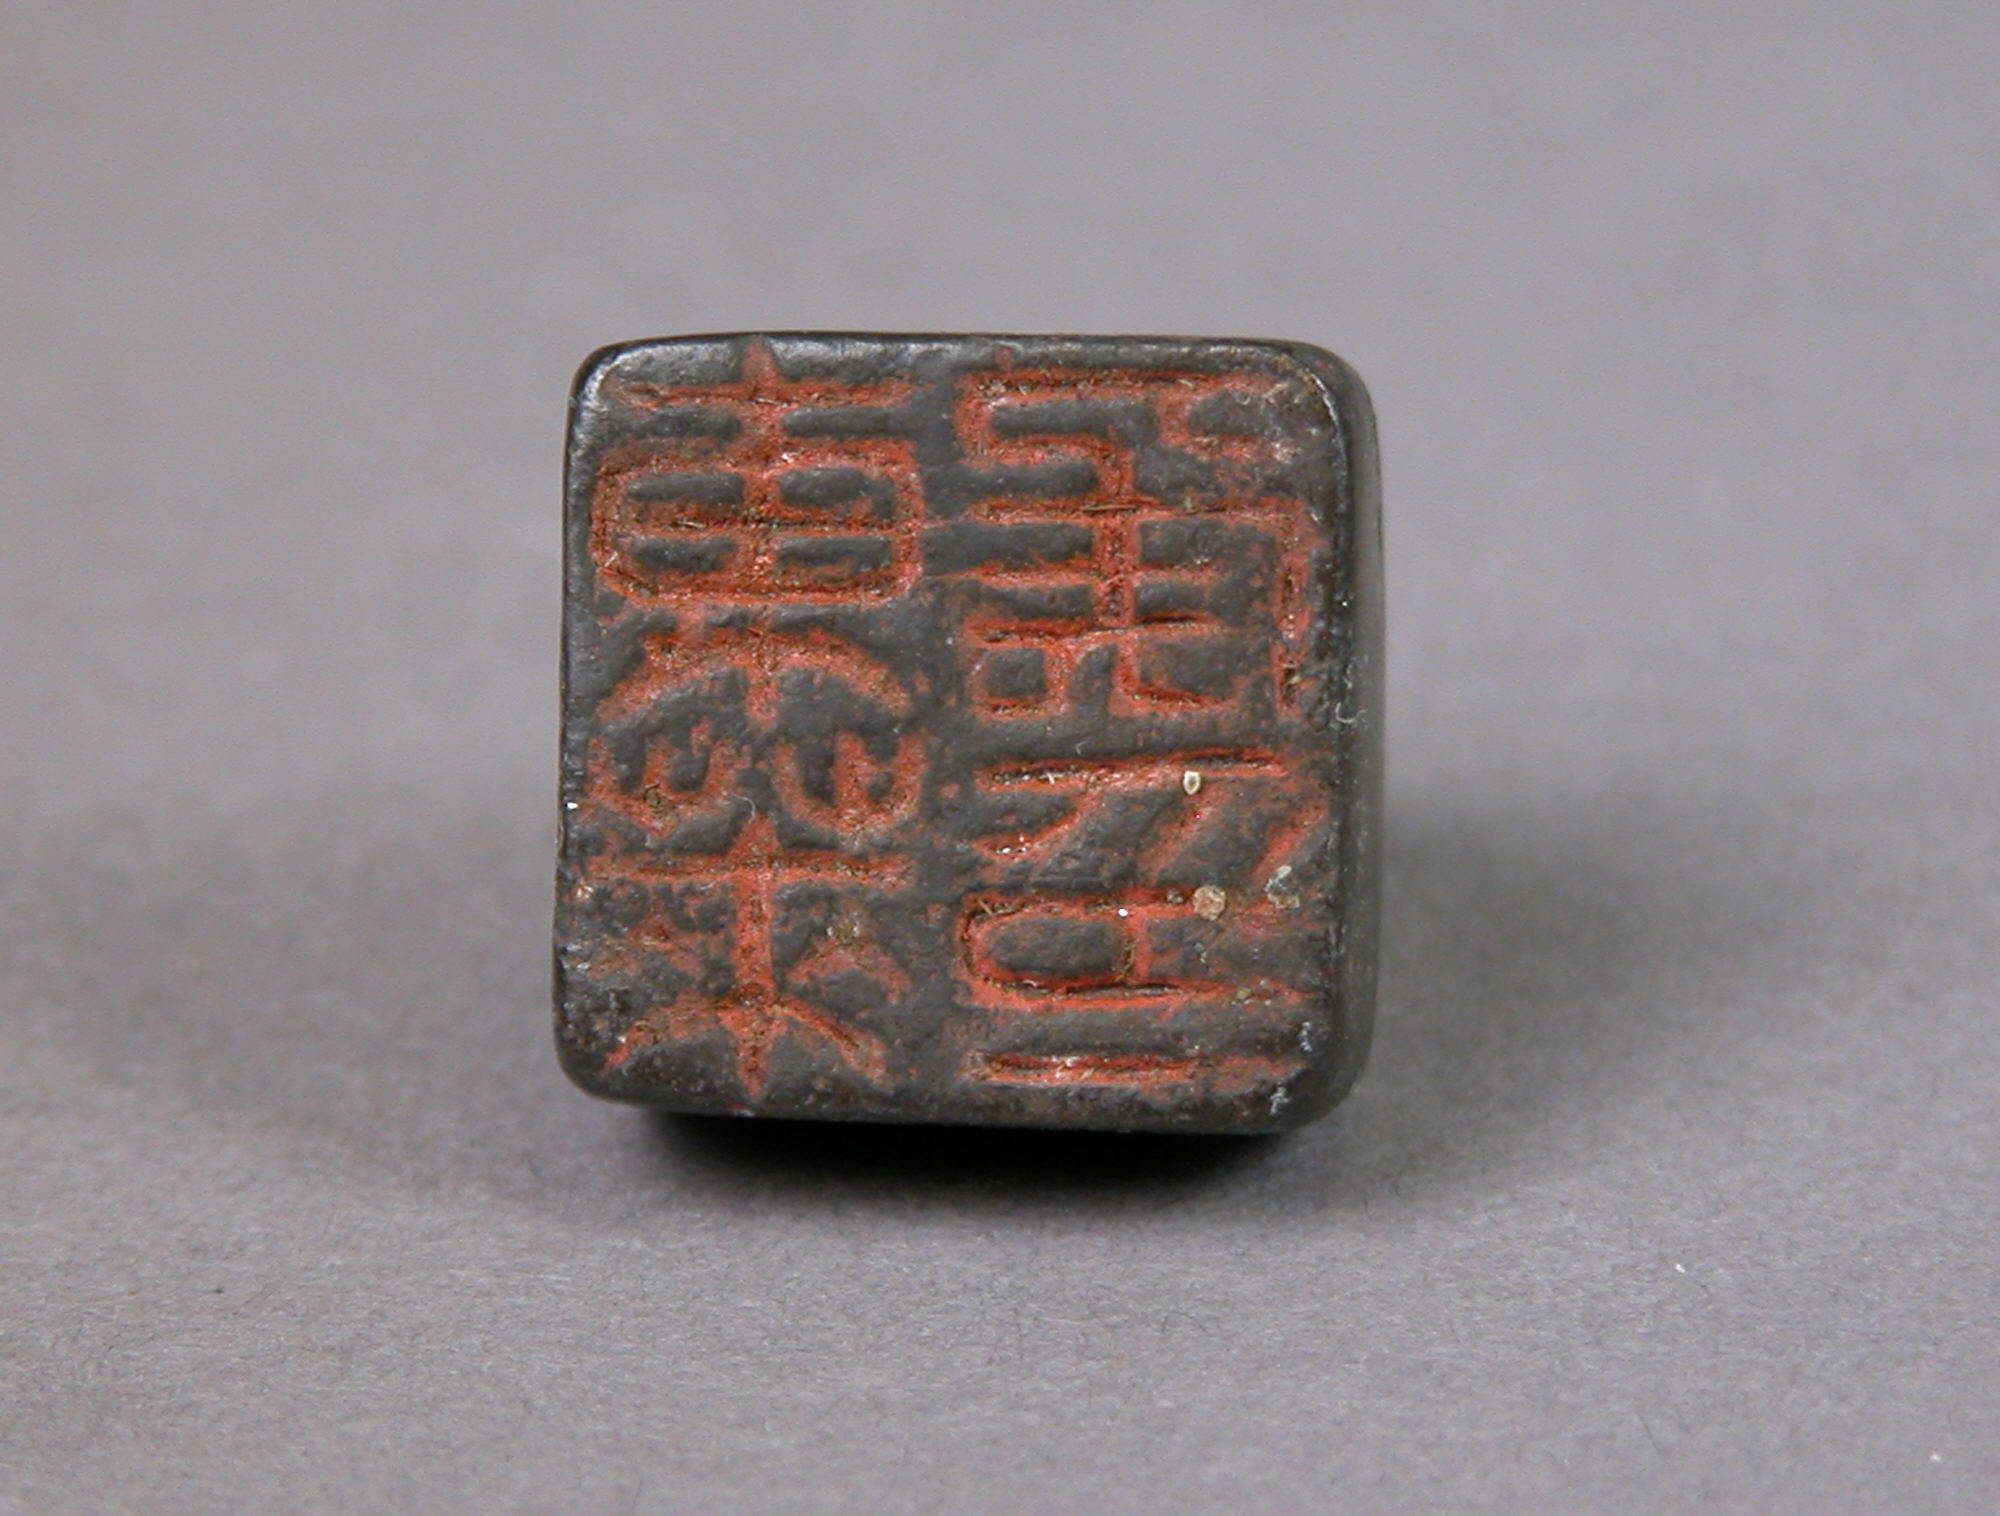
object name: seal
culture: chinese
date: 1300-1644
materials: bronze